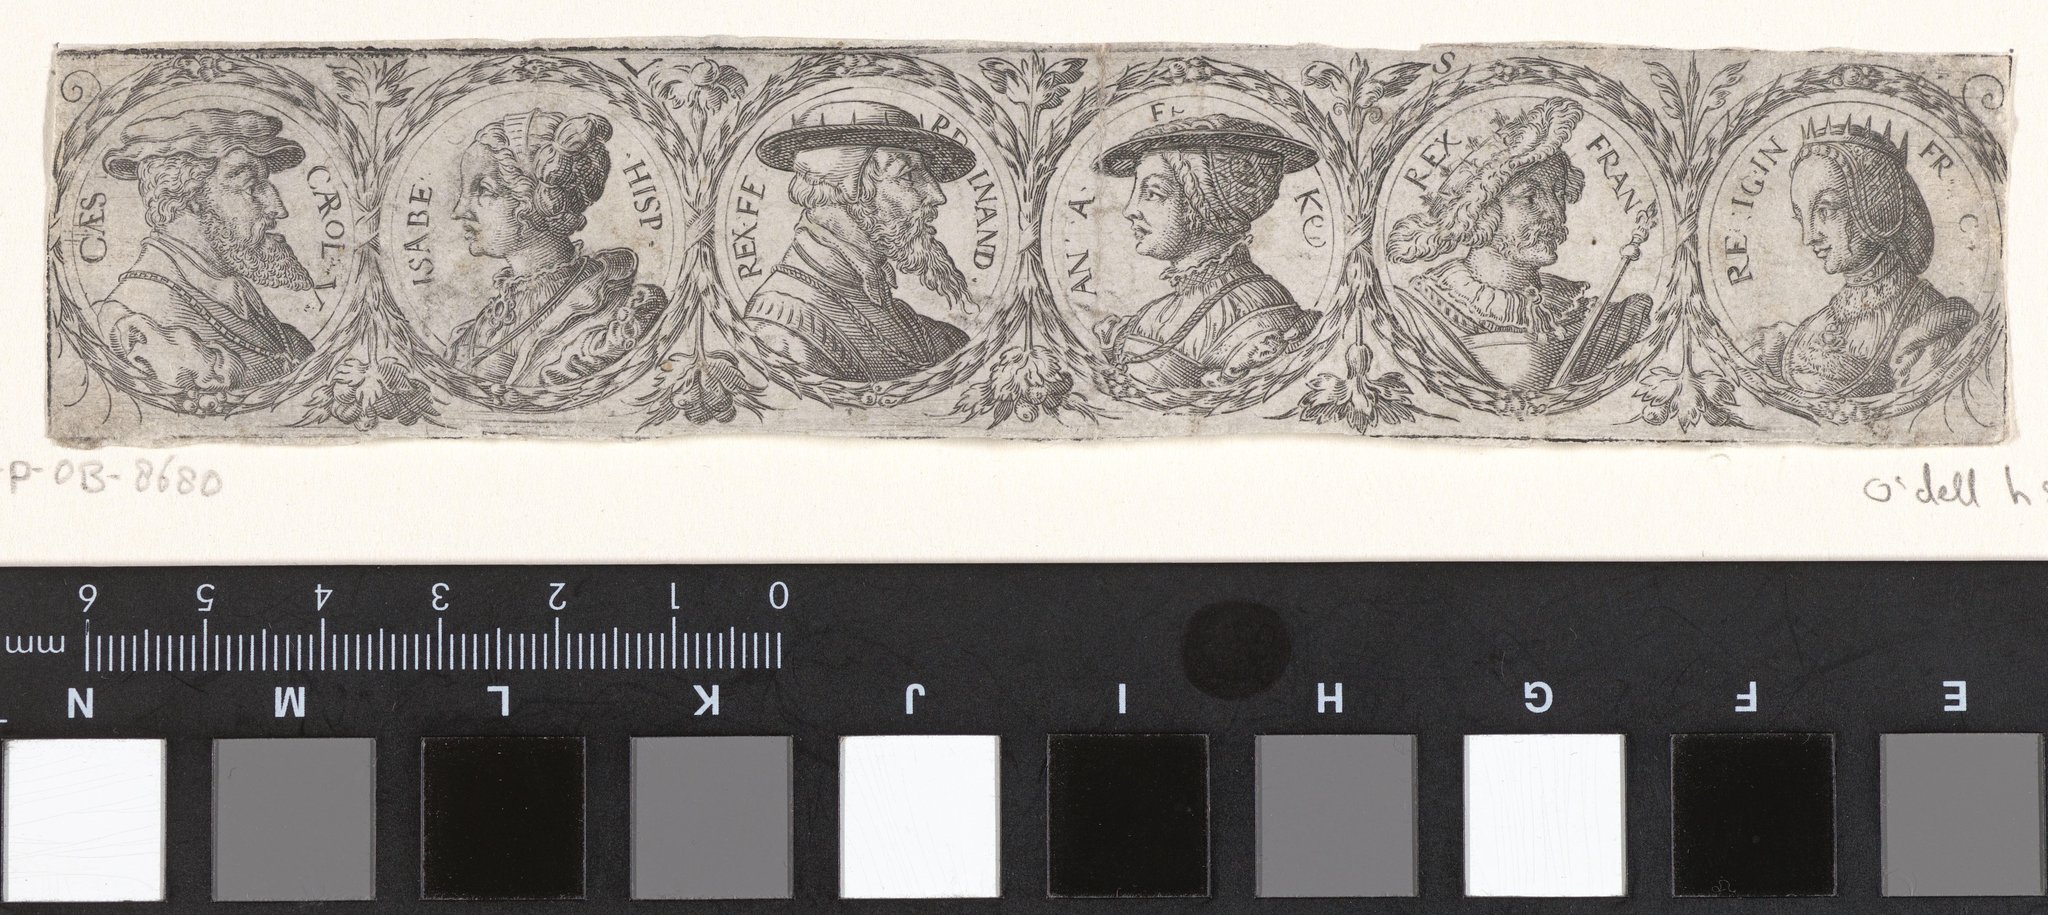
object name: print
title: Fries met zes busten in lauwerkranzen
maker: virgilius solis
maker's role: draughtsman, print maker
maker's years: 1514-1562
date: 1524-1562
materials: paper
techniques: engraving